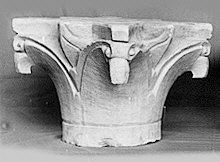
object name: capital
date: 501-700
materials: limestone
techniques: carving, relief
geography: egypt